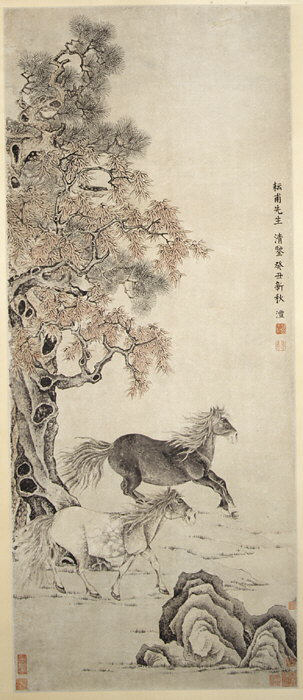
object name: hanging scroll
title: Two Horses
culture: chinese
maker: unidentified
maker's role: artist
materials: ink, paper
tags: horses,trees